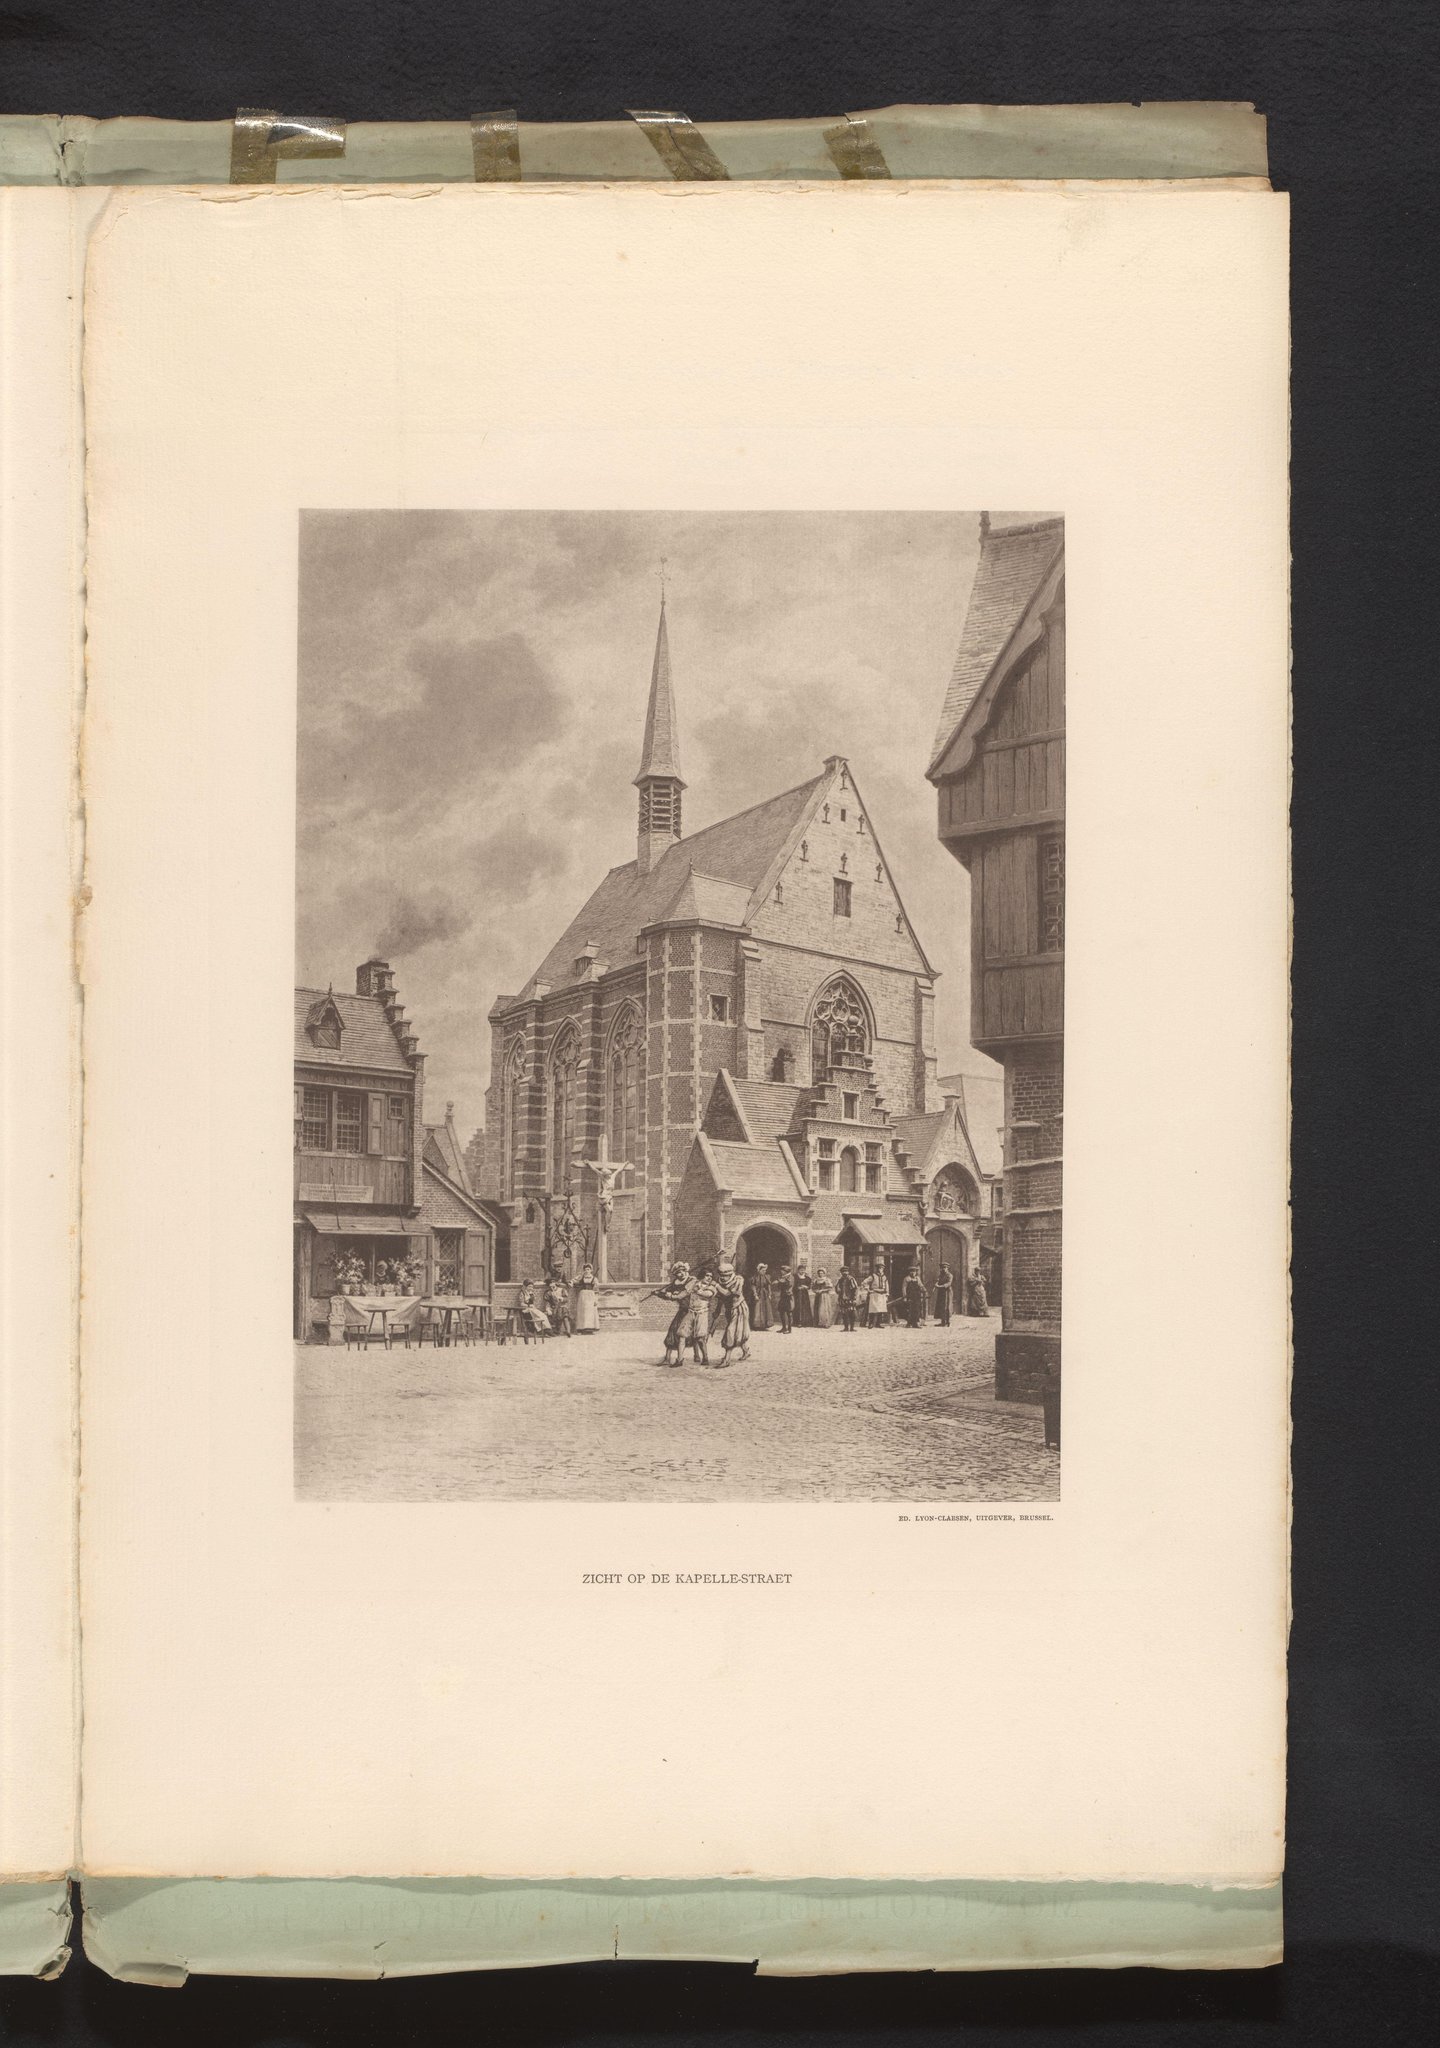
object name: page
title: Gezicht op de Kapellestraat in Oud-Antwerpen op de Wereldtentoonstelling van 1894 in Antwerpen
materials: paper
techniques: photograph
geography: brussels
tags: world fair, world exhibition, street, antwerp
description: Prent op los blad tussen pagina 22 en 23.